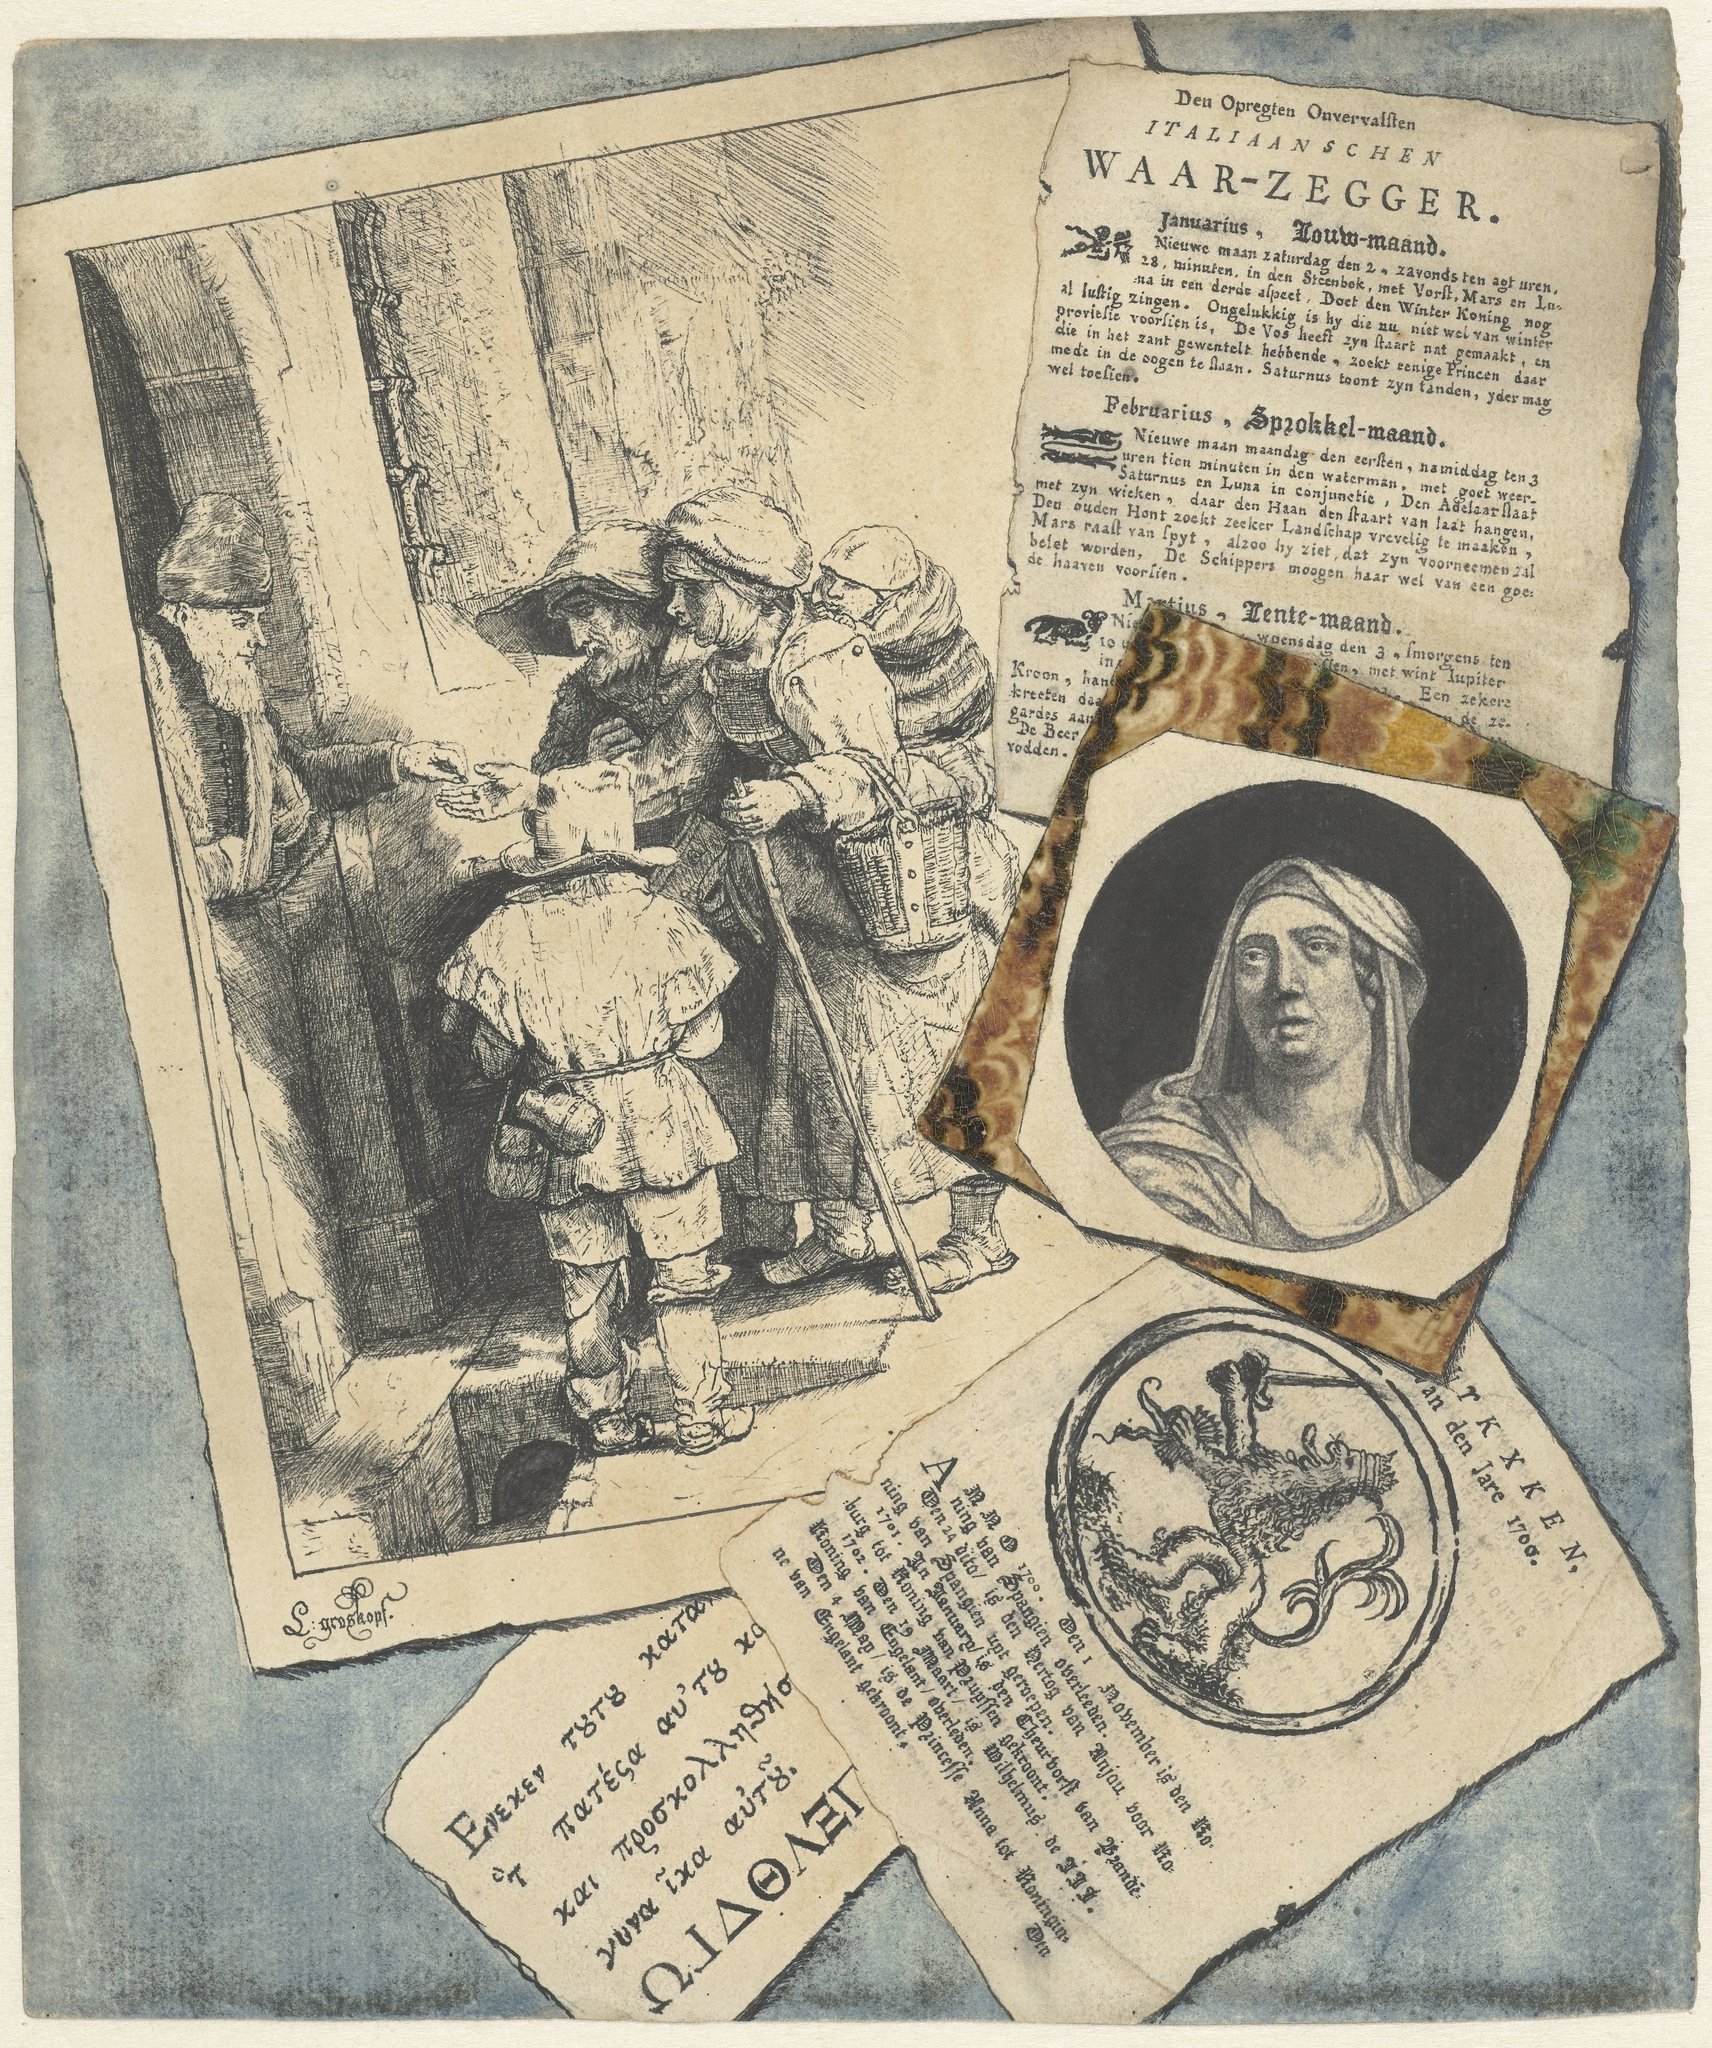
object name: drawing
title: Trompe-l'oeil met prenten en pamfletten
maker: l. groskopf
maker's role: draughtsman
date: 1746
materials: ink, paper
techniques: brush, pen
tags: 'trompe l'oeil', print, e.g.: engraving, etching, lithograph, picture within picture